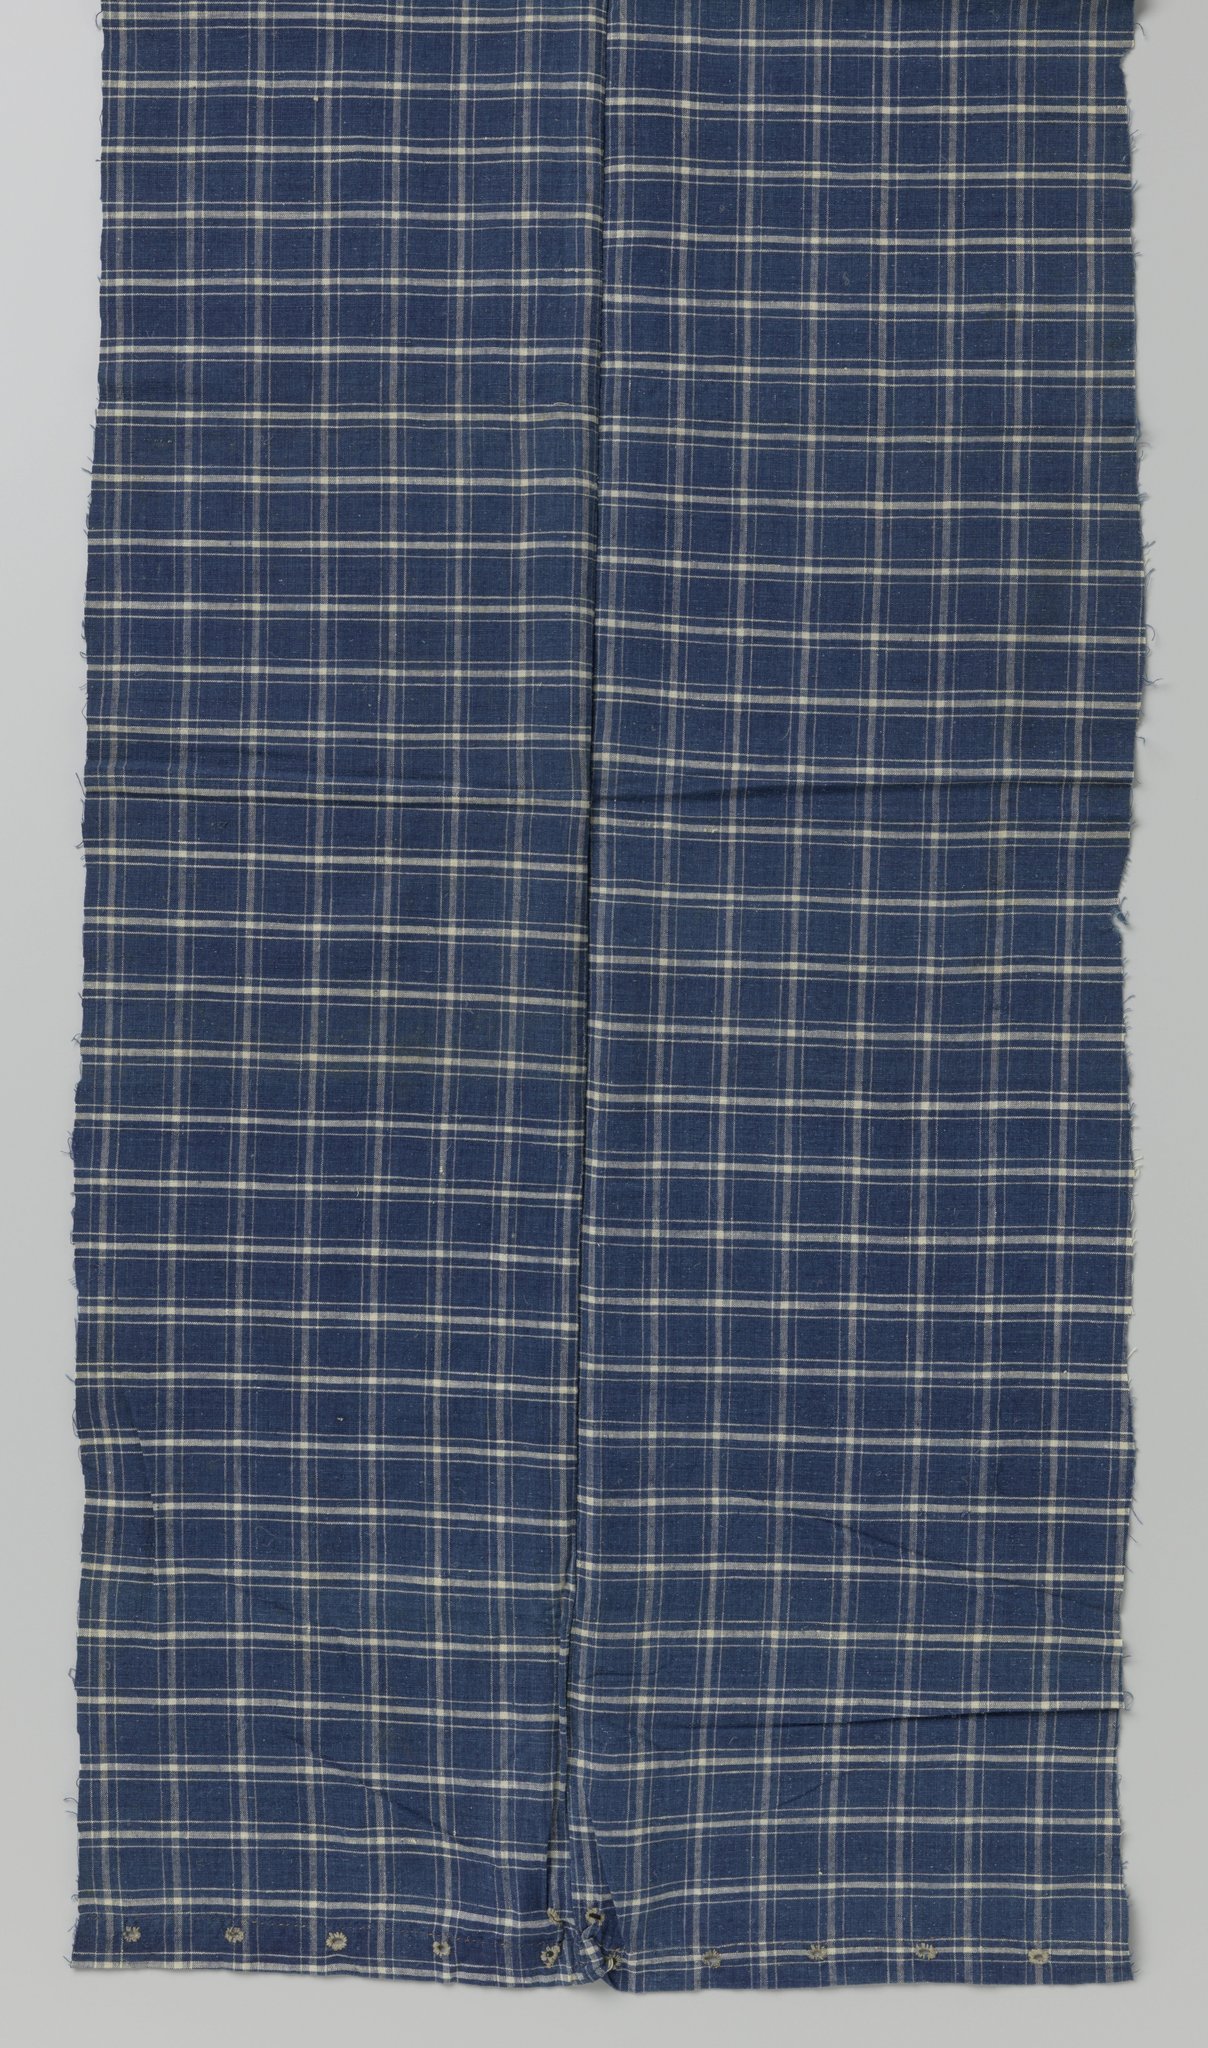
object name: tick covering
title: Fragment van een katoenen beddentijk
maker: Anonymous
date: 1800-1950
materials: cotton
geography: netherlands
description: Fragment van een katoenen beddentijk, blauw met een witte ruit.